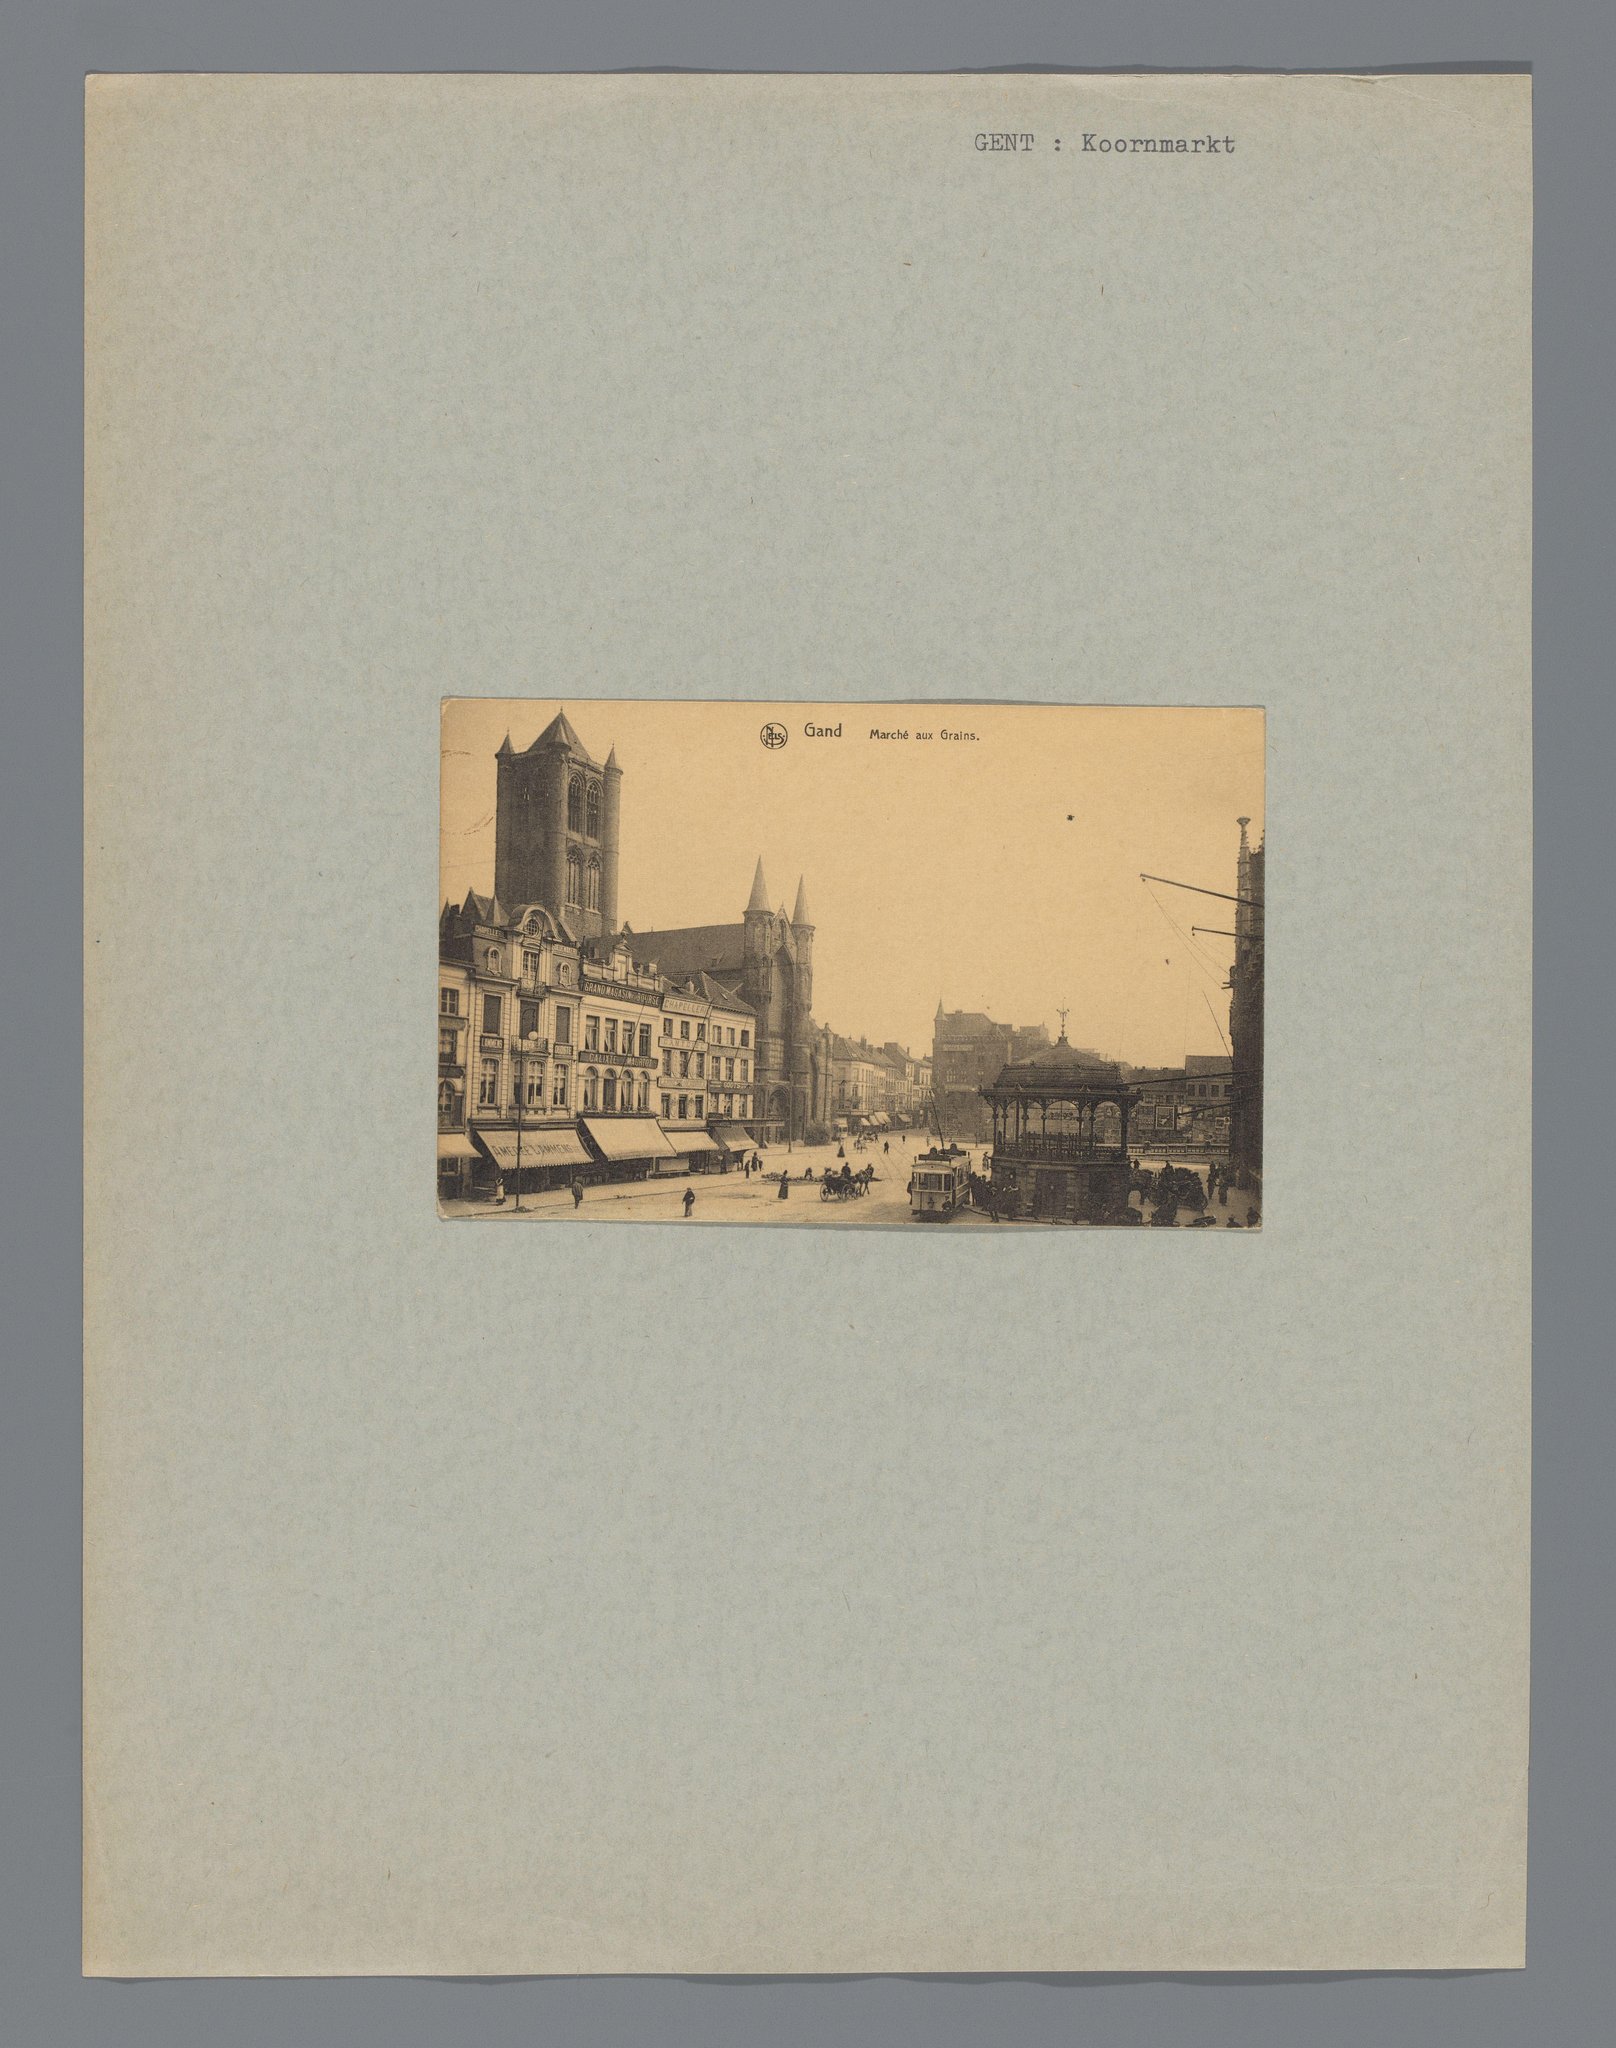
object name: photograph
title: Gent. Koornmarkt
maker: Anonymous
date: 1860-1925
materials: photographic support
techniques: photograph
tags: ghent